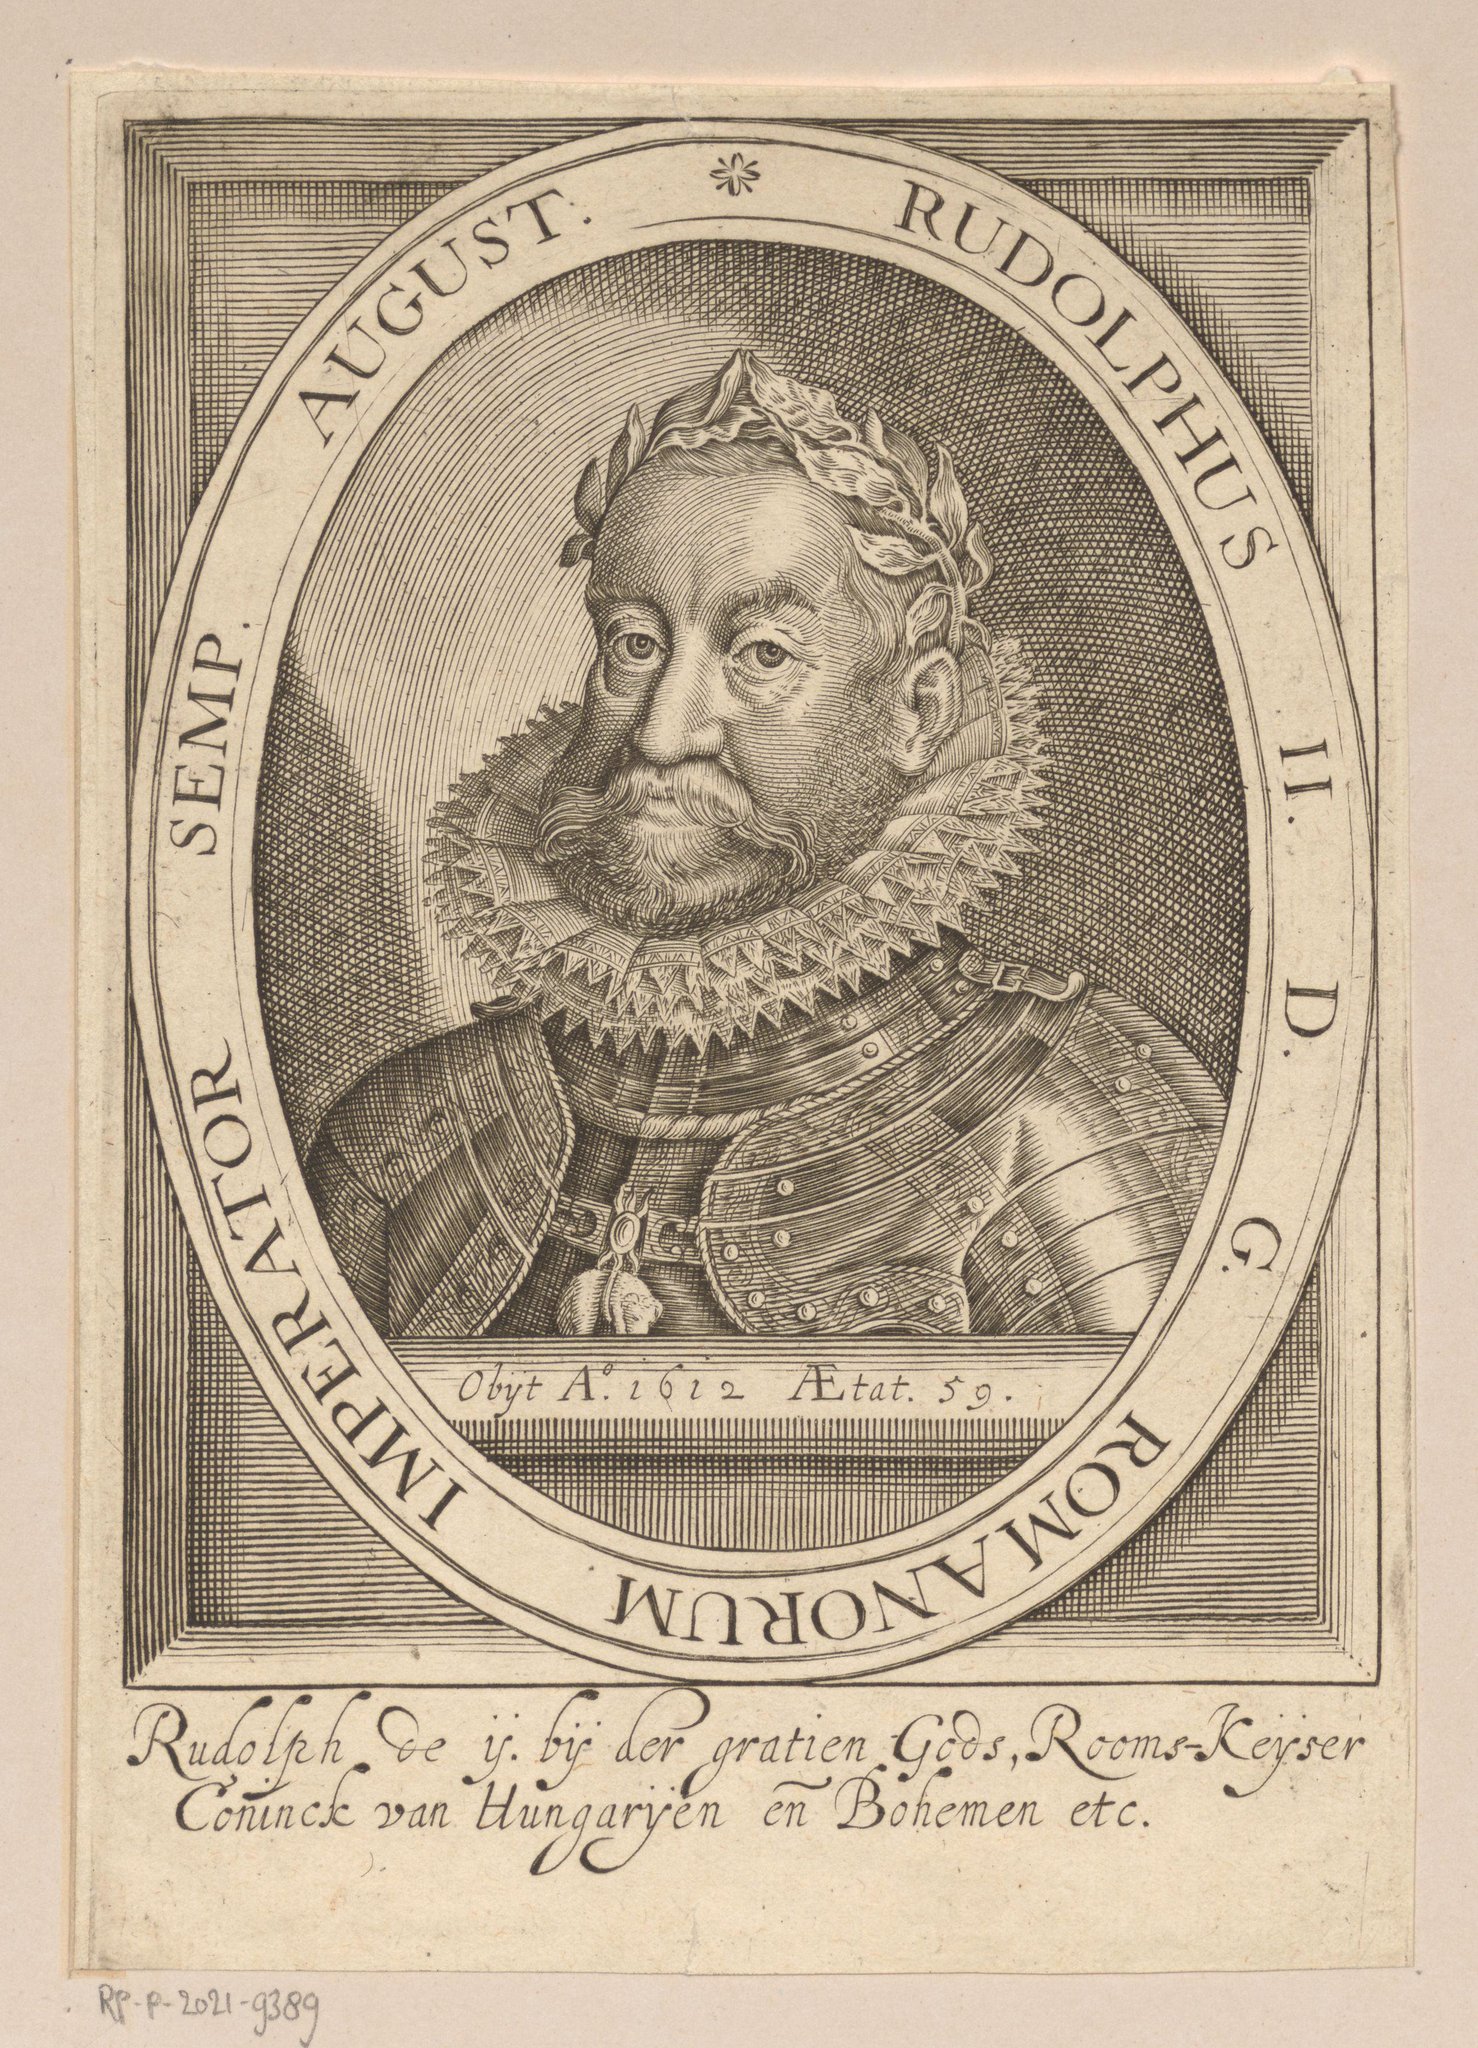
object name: print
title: Portret van Rudolf II van Habsburg, Duits keizer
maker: Anonymous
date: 1612-1699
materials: paper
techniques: engraving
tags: vienna, rudolf ii van habsburg (duits keizer), armour, historical persons, knighthood order of the golden fleece